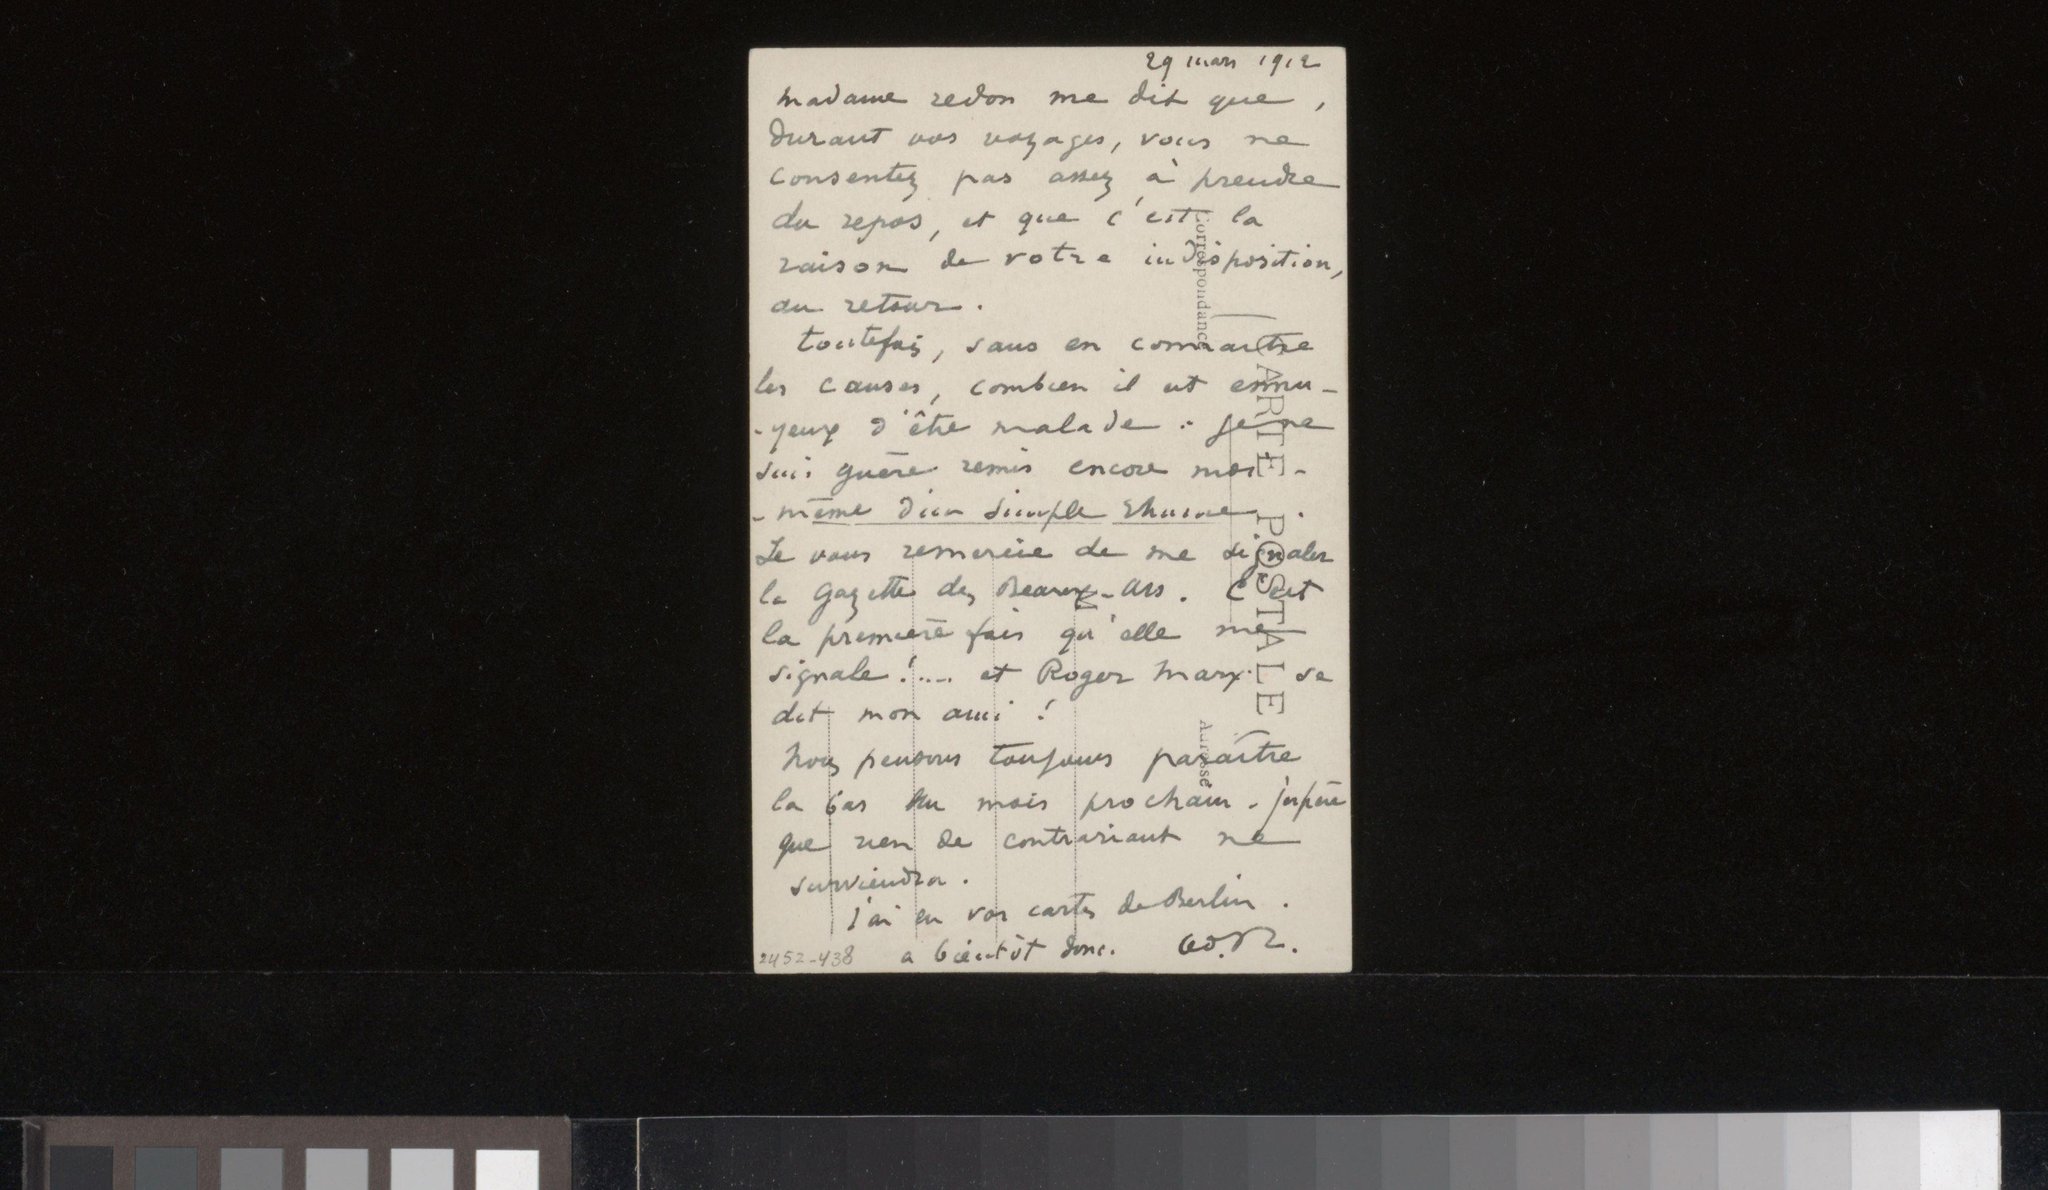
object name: ansichtkaart, prentbriefkaart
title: Prentbriefkaart aan Andries Bonger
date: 1912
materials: cardboard, ink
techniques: pen, printing, writing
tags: amsterdam, andries bonger, roger marx, berlin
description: Prentbriefkaart behoort tot een album samengesteld door weduwe Françoise W.M. Barones van der Borch van Verwolde met afschriften van brieven met betrekking tot (de familie van) Odilon Redon. De prentbriefkaart werd bewaard op pagina 185.